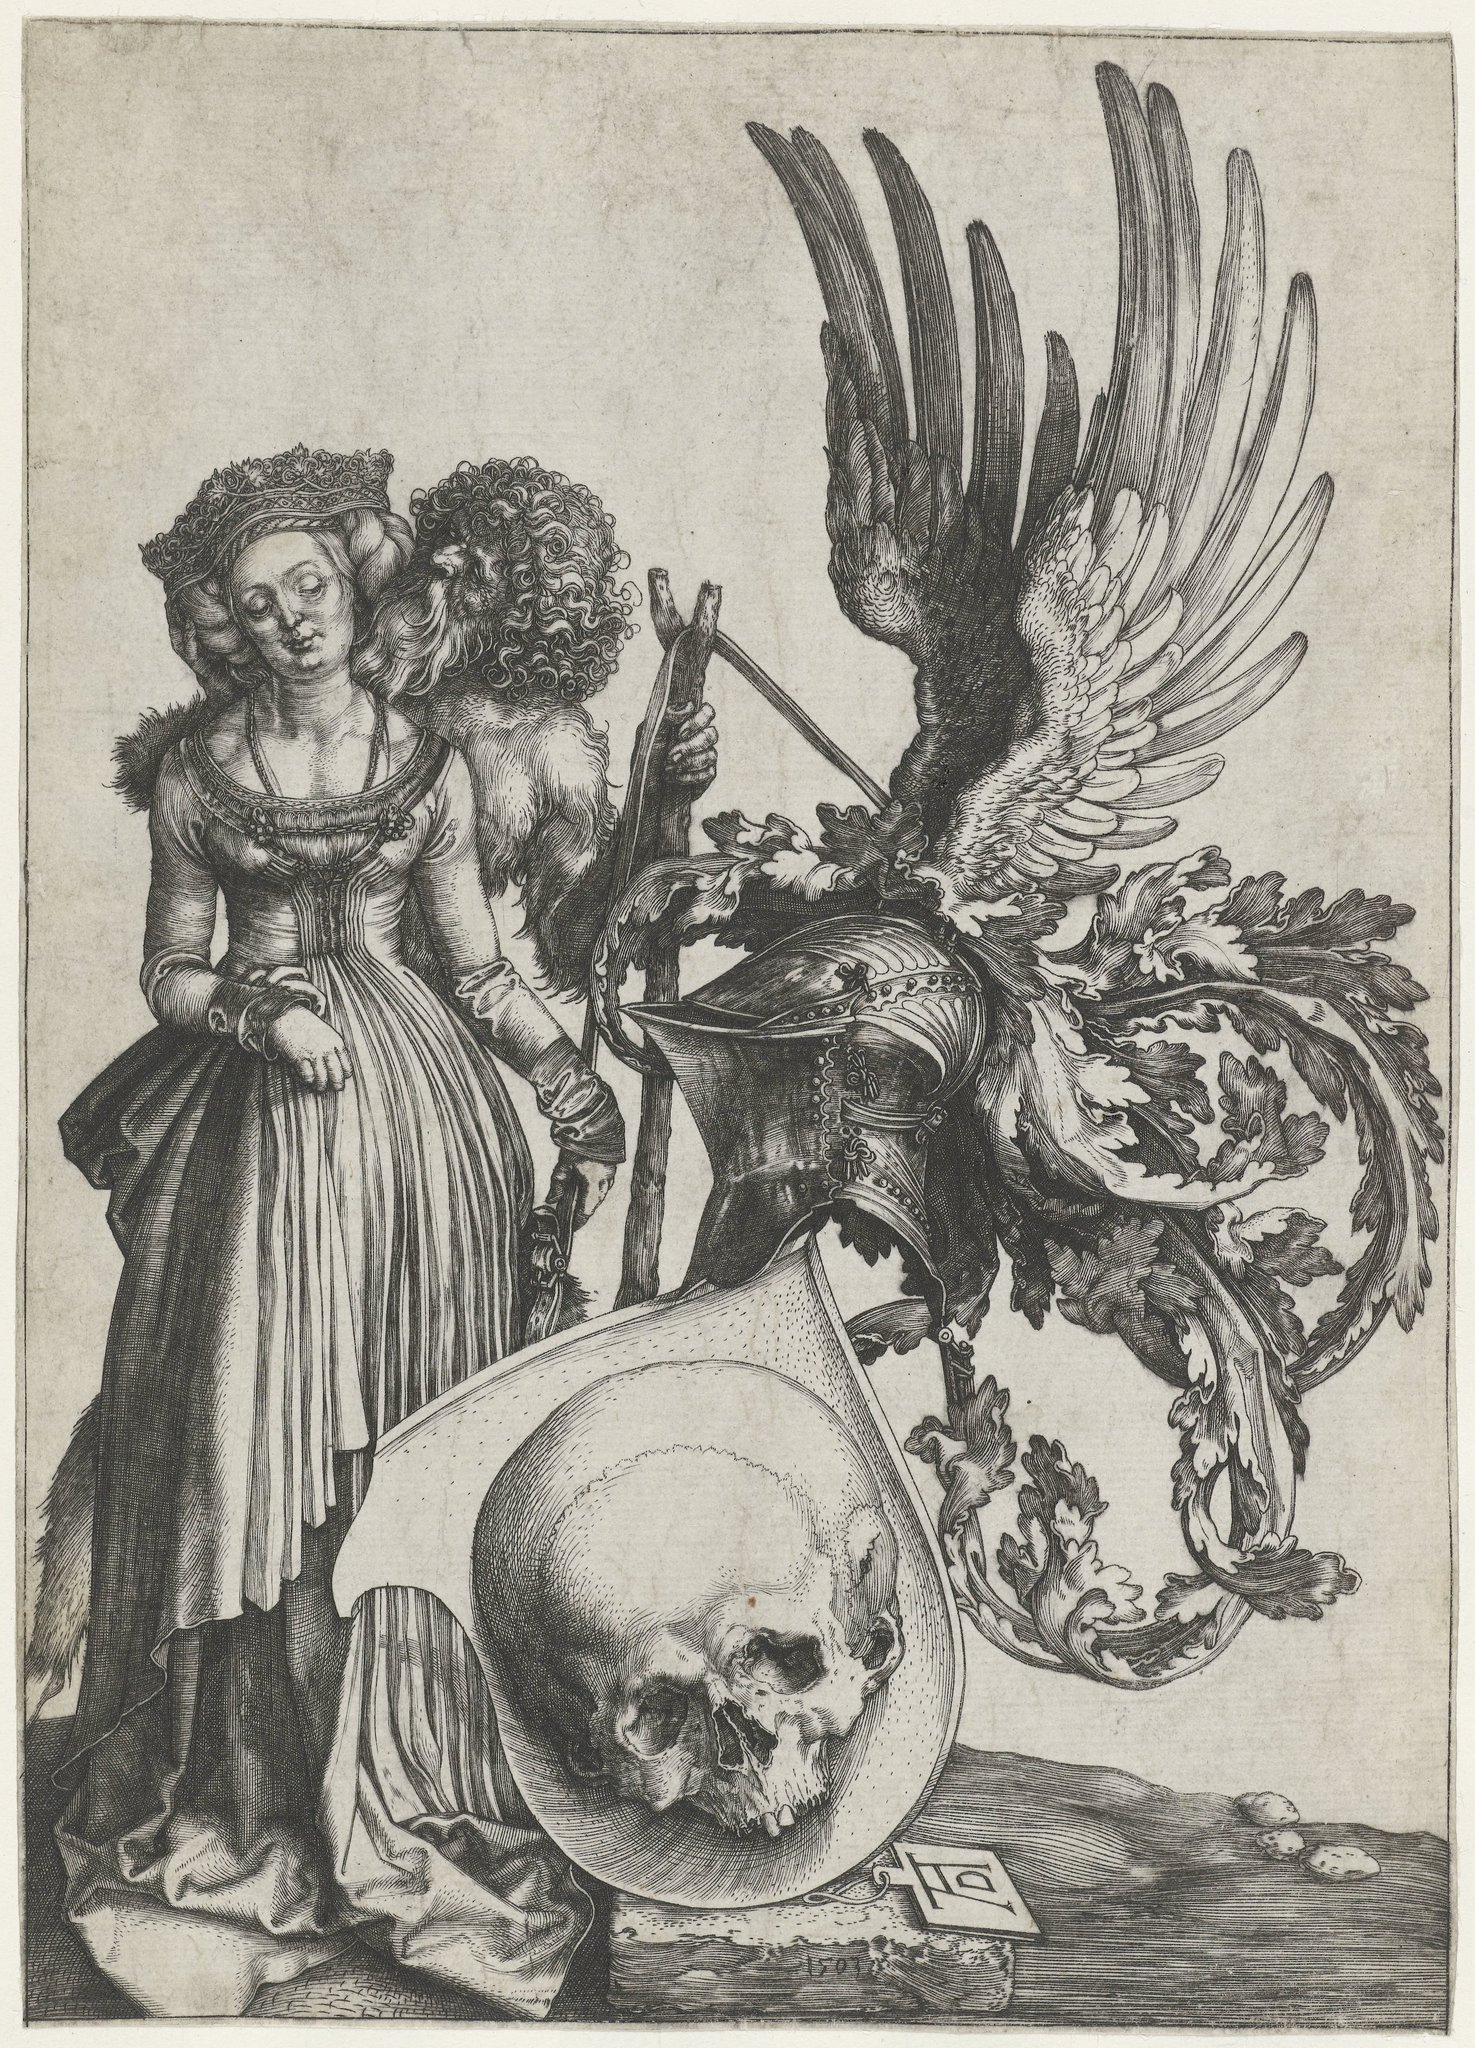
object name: print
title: Wapenschild met vrouw en wildeman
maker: albrecht dürer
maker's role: draughtsman, painter, print maker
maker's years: 1471-1528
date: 1503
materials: paper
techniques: engraving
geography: nuremberg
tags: helmet, wild man, wodewose, woodehouse, (human) skull, armorial bearing, heraldry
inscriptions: collector's mark: Lugt 240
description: Een wapenschild met een schedel erop. Op het schild rust een helm, waaraan vleugels en bladeren bevestigd zijn. Achter het wapenschild staan een vrouw en een wildeman.